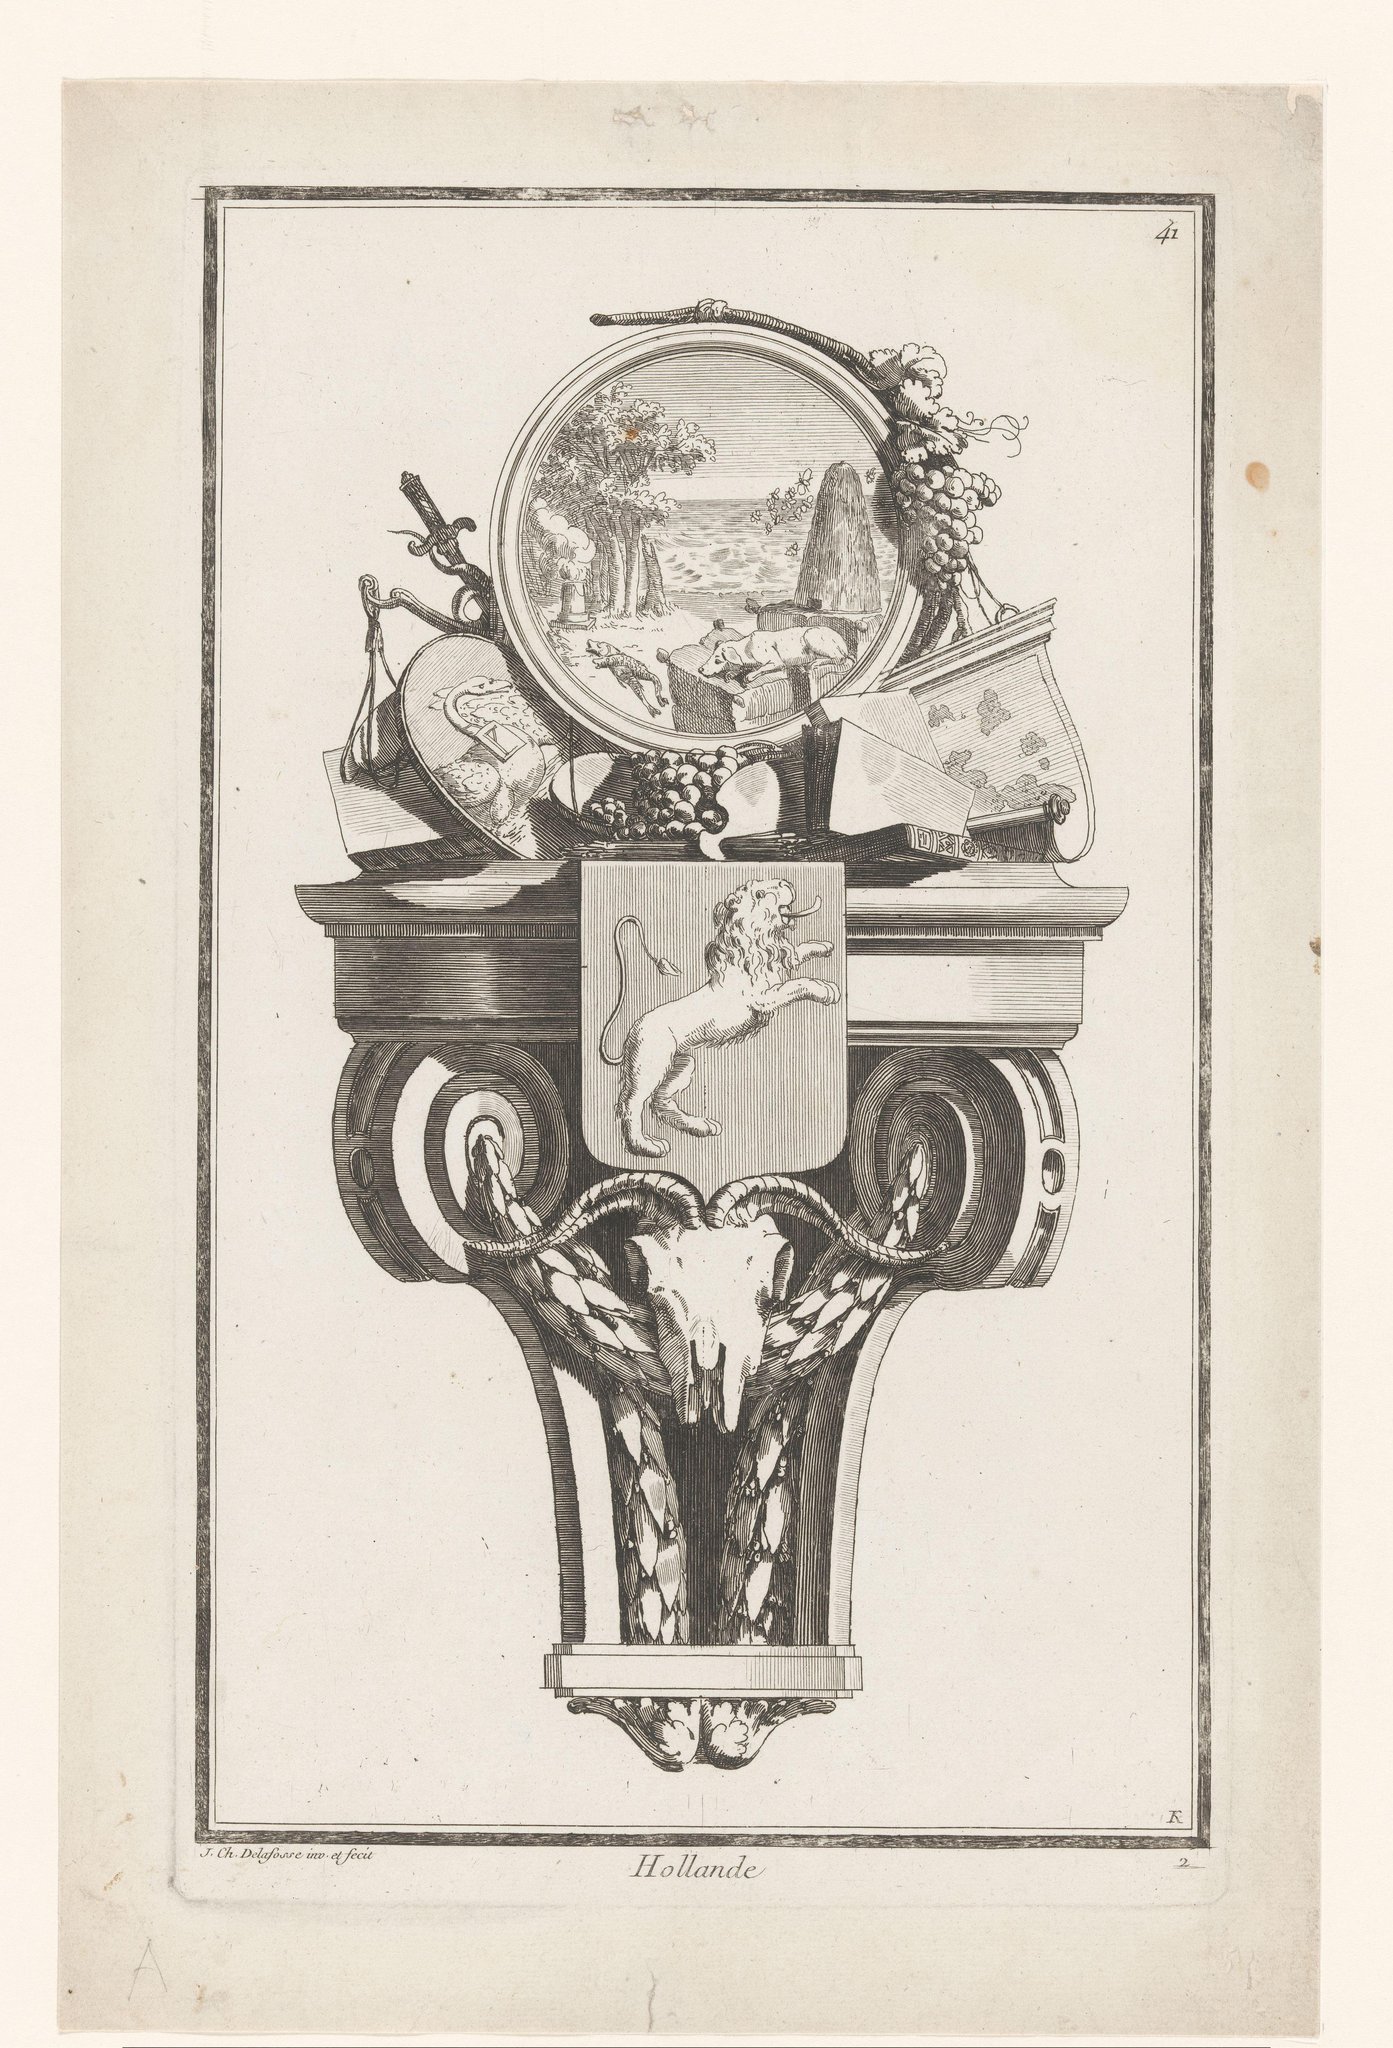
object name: print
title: Hollande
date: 1768-1771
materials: paper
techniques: engraving, etching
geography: paris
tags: other architectural details (console), holland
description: Een geornamenteerde console met voluten en een dierenschedel, daarboven een wapen met een leeuw, boeken, druiventrossen, een weegschaal, een kaart, een medaillon met een zwaan en een rond medaillon met een bijenkorf en een rustende hond aan zee. Prentnummer 41.